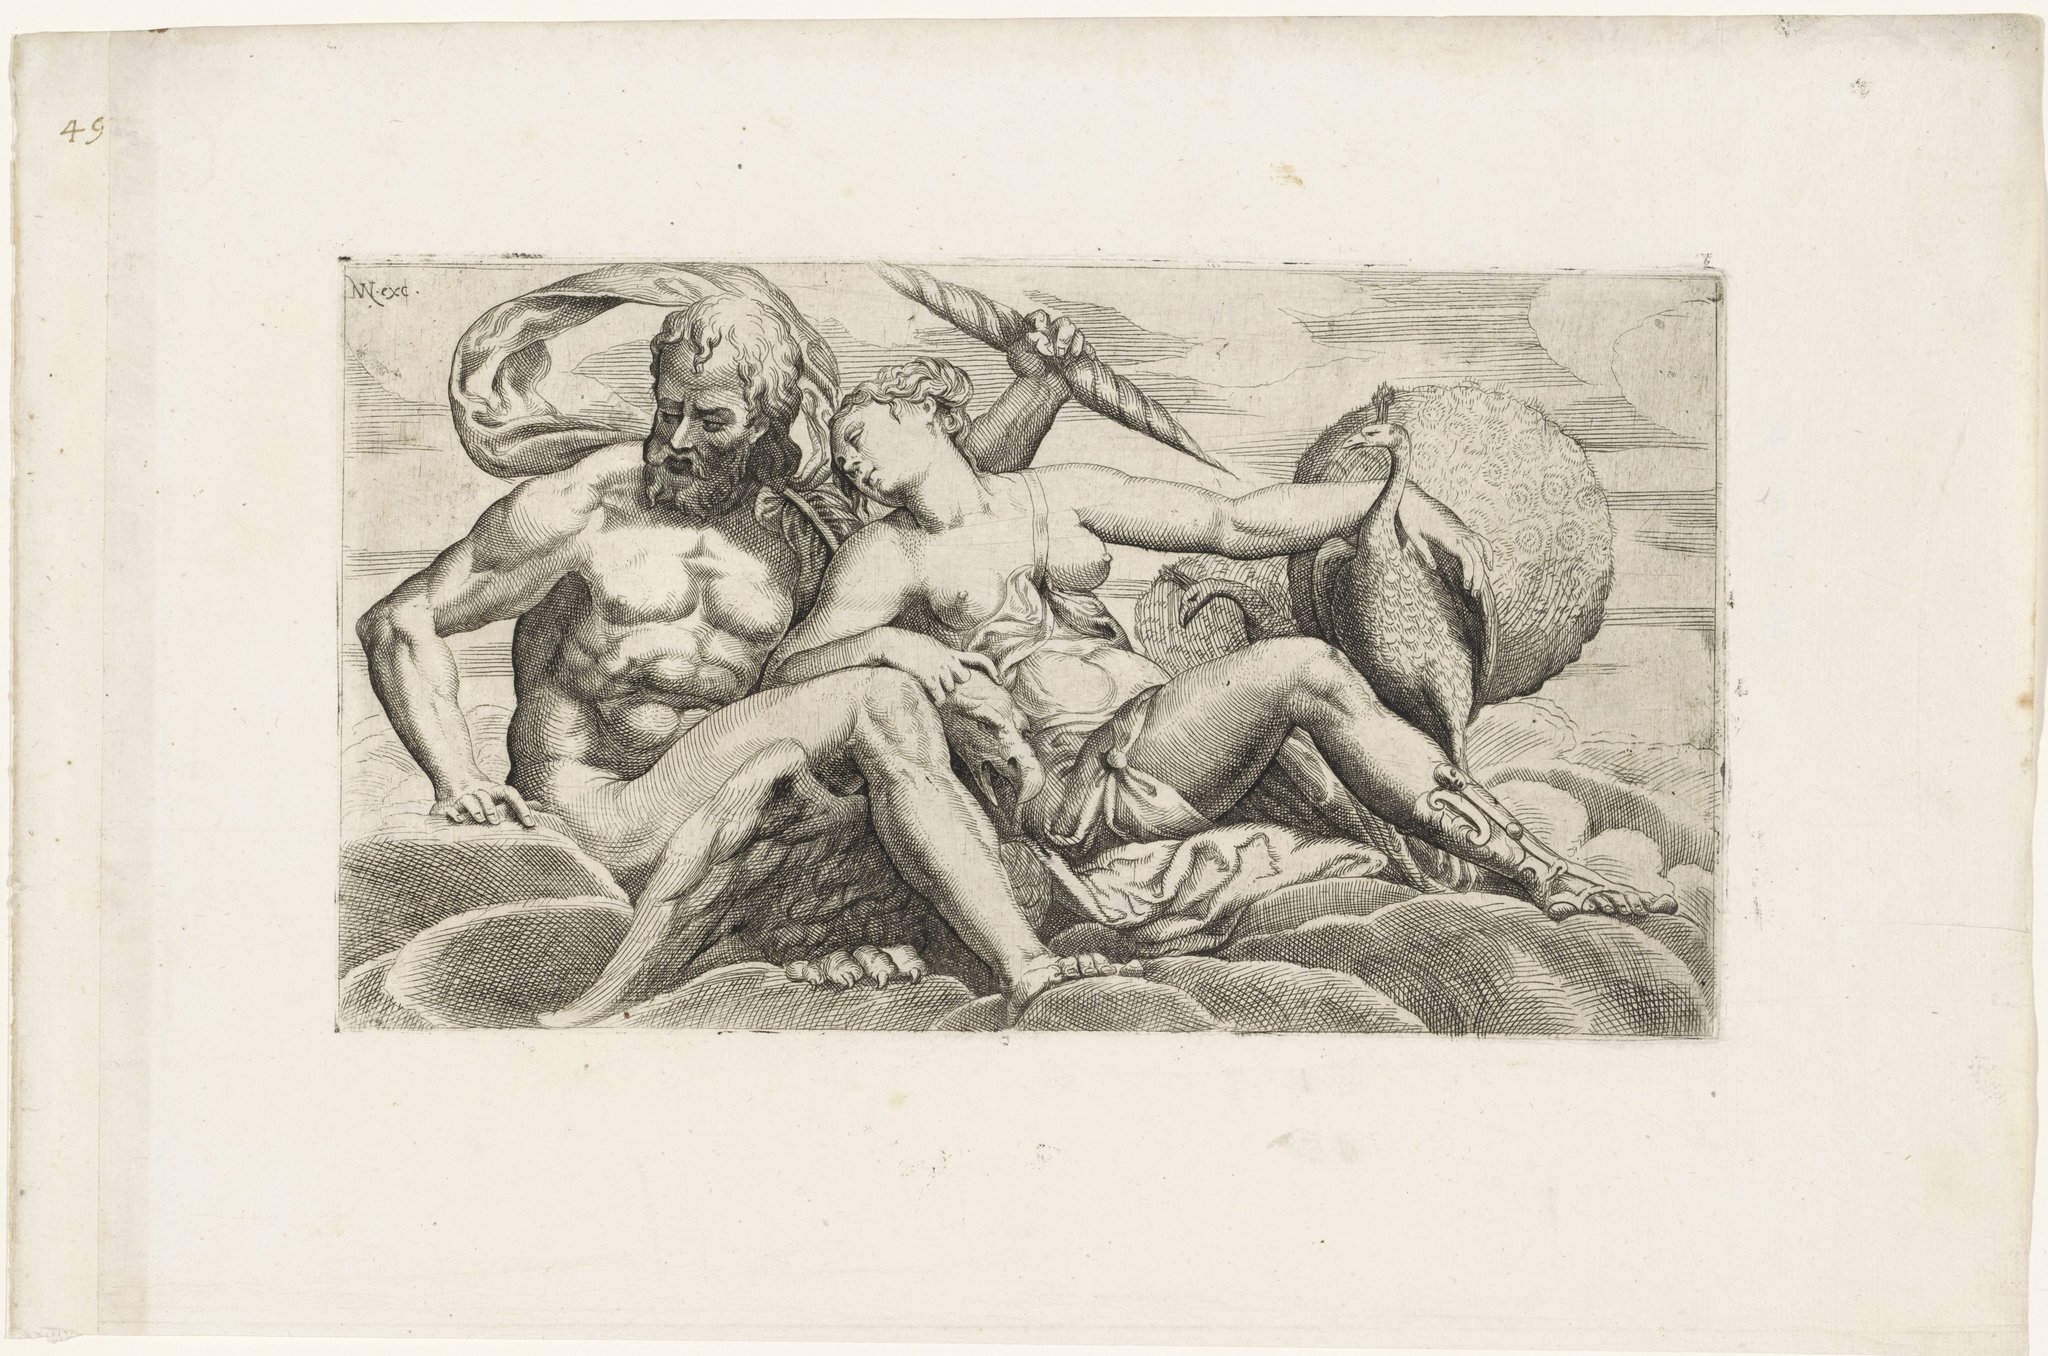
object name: album leaf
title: Jupiter en Juno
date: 1540-1570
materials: paper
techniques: engraving, etching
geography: italy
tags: jupiter and juno as king and queen of heaven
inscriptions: collector's mark: Lugt 2228, collector's mark: Lugt 2760, number: ‘49’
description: Folio 49 uit het prentalbum van Johann Georg I. Zobel von Giebelstadt (Röttingen 1543-07-20 - Bamberg 1580-09-07), de latere bisschop van Bamberg. Het album is vermoedelijk samengesteld tussen 1568 en 1570 in Venetië. Het album werd in 1999 uit elkaar genomen door een antiquair. De in totaal 124 folio's met prenten uit het "Zobel Album" werden aangekocht door verschillende musea en privéverzamelingen. De grootste groep (68 folio's) bevindt zich in de collectie van het Rijksmuseum. Bovenste helft van een folio met twee prenten. Onderste helft is vermist.